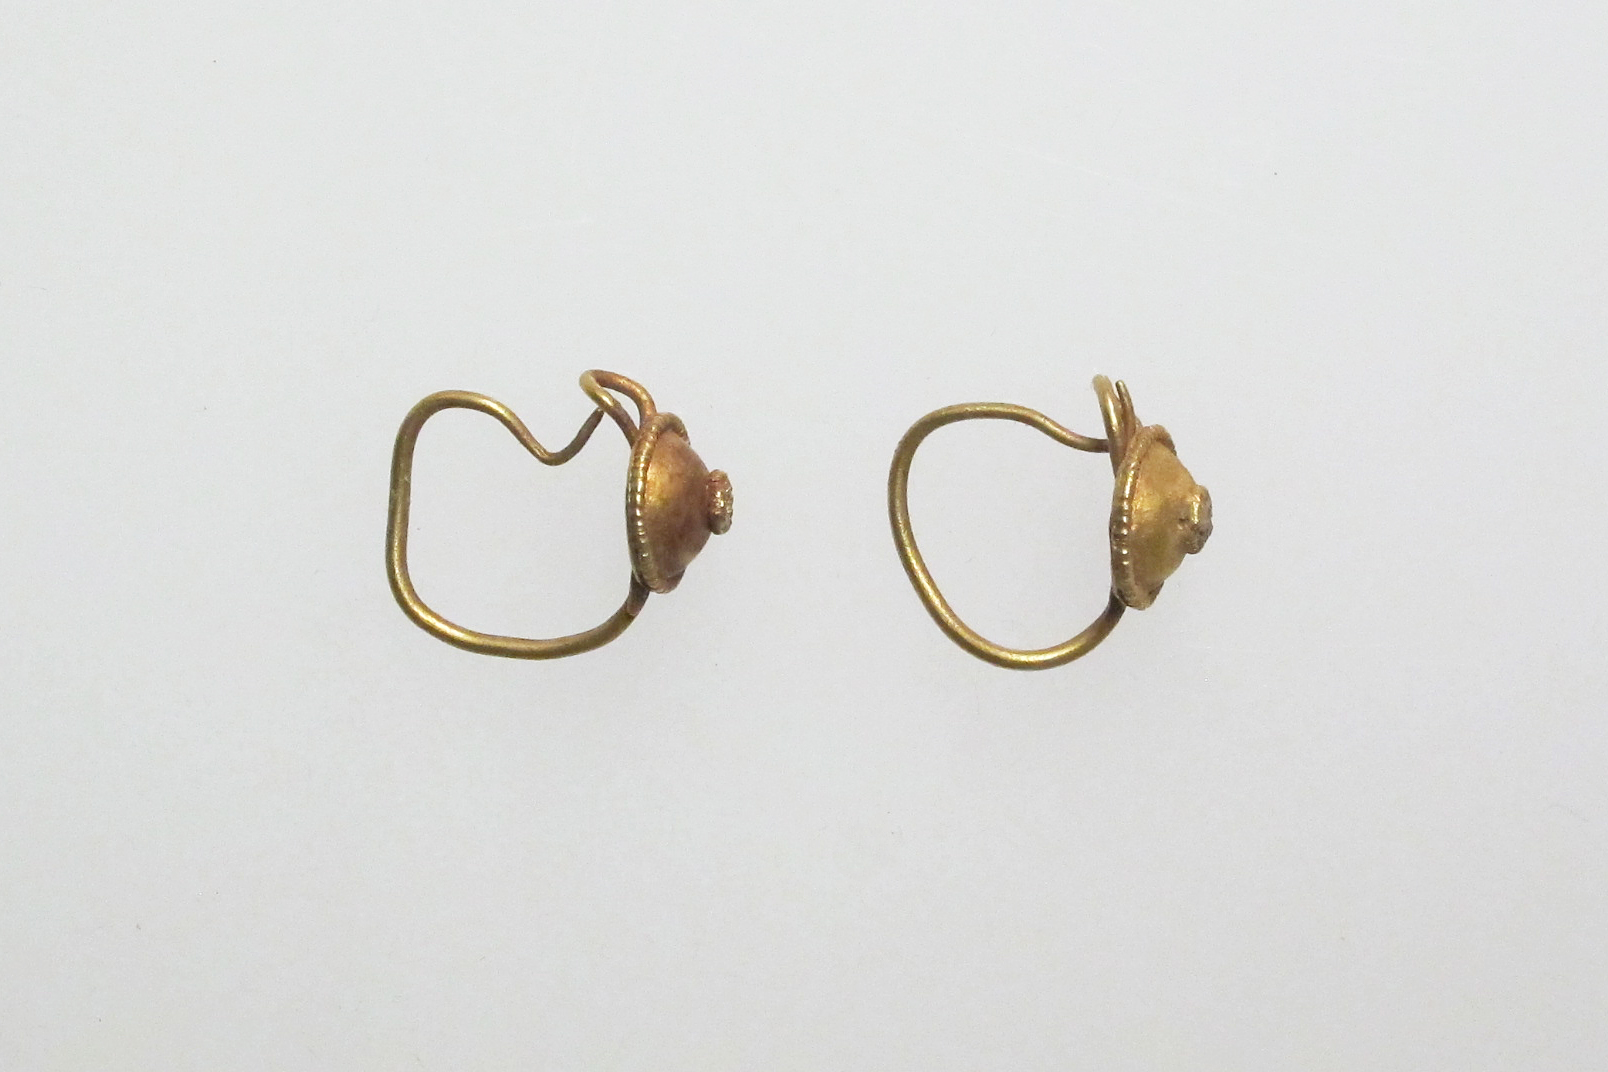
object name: earring disk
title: Earring with disks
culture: greek or roman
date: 7000 BCE-330 CE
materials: gold